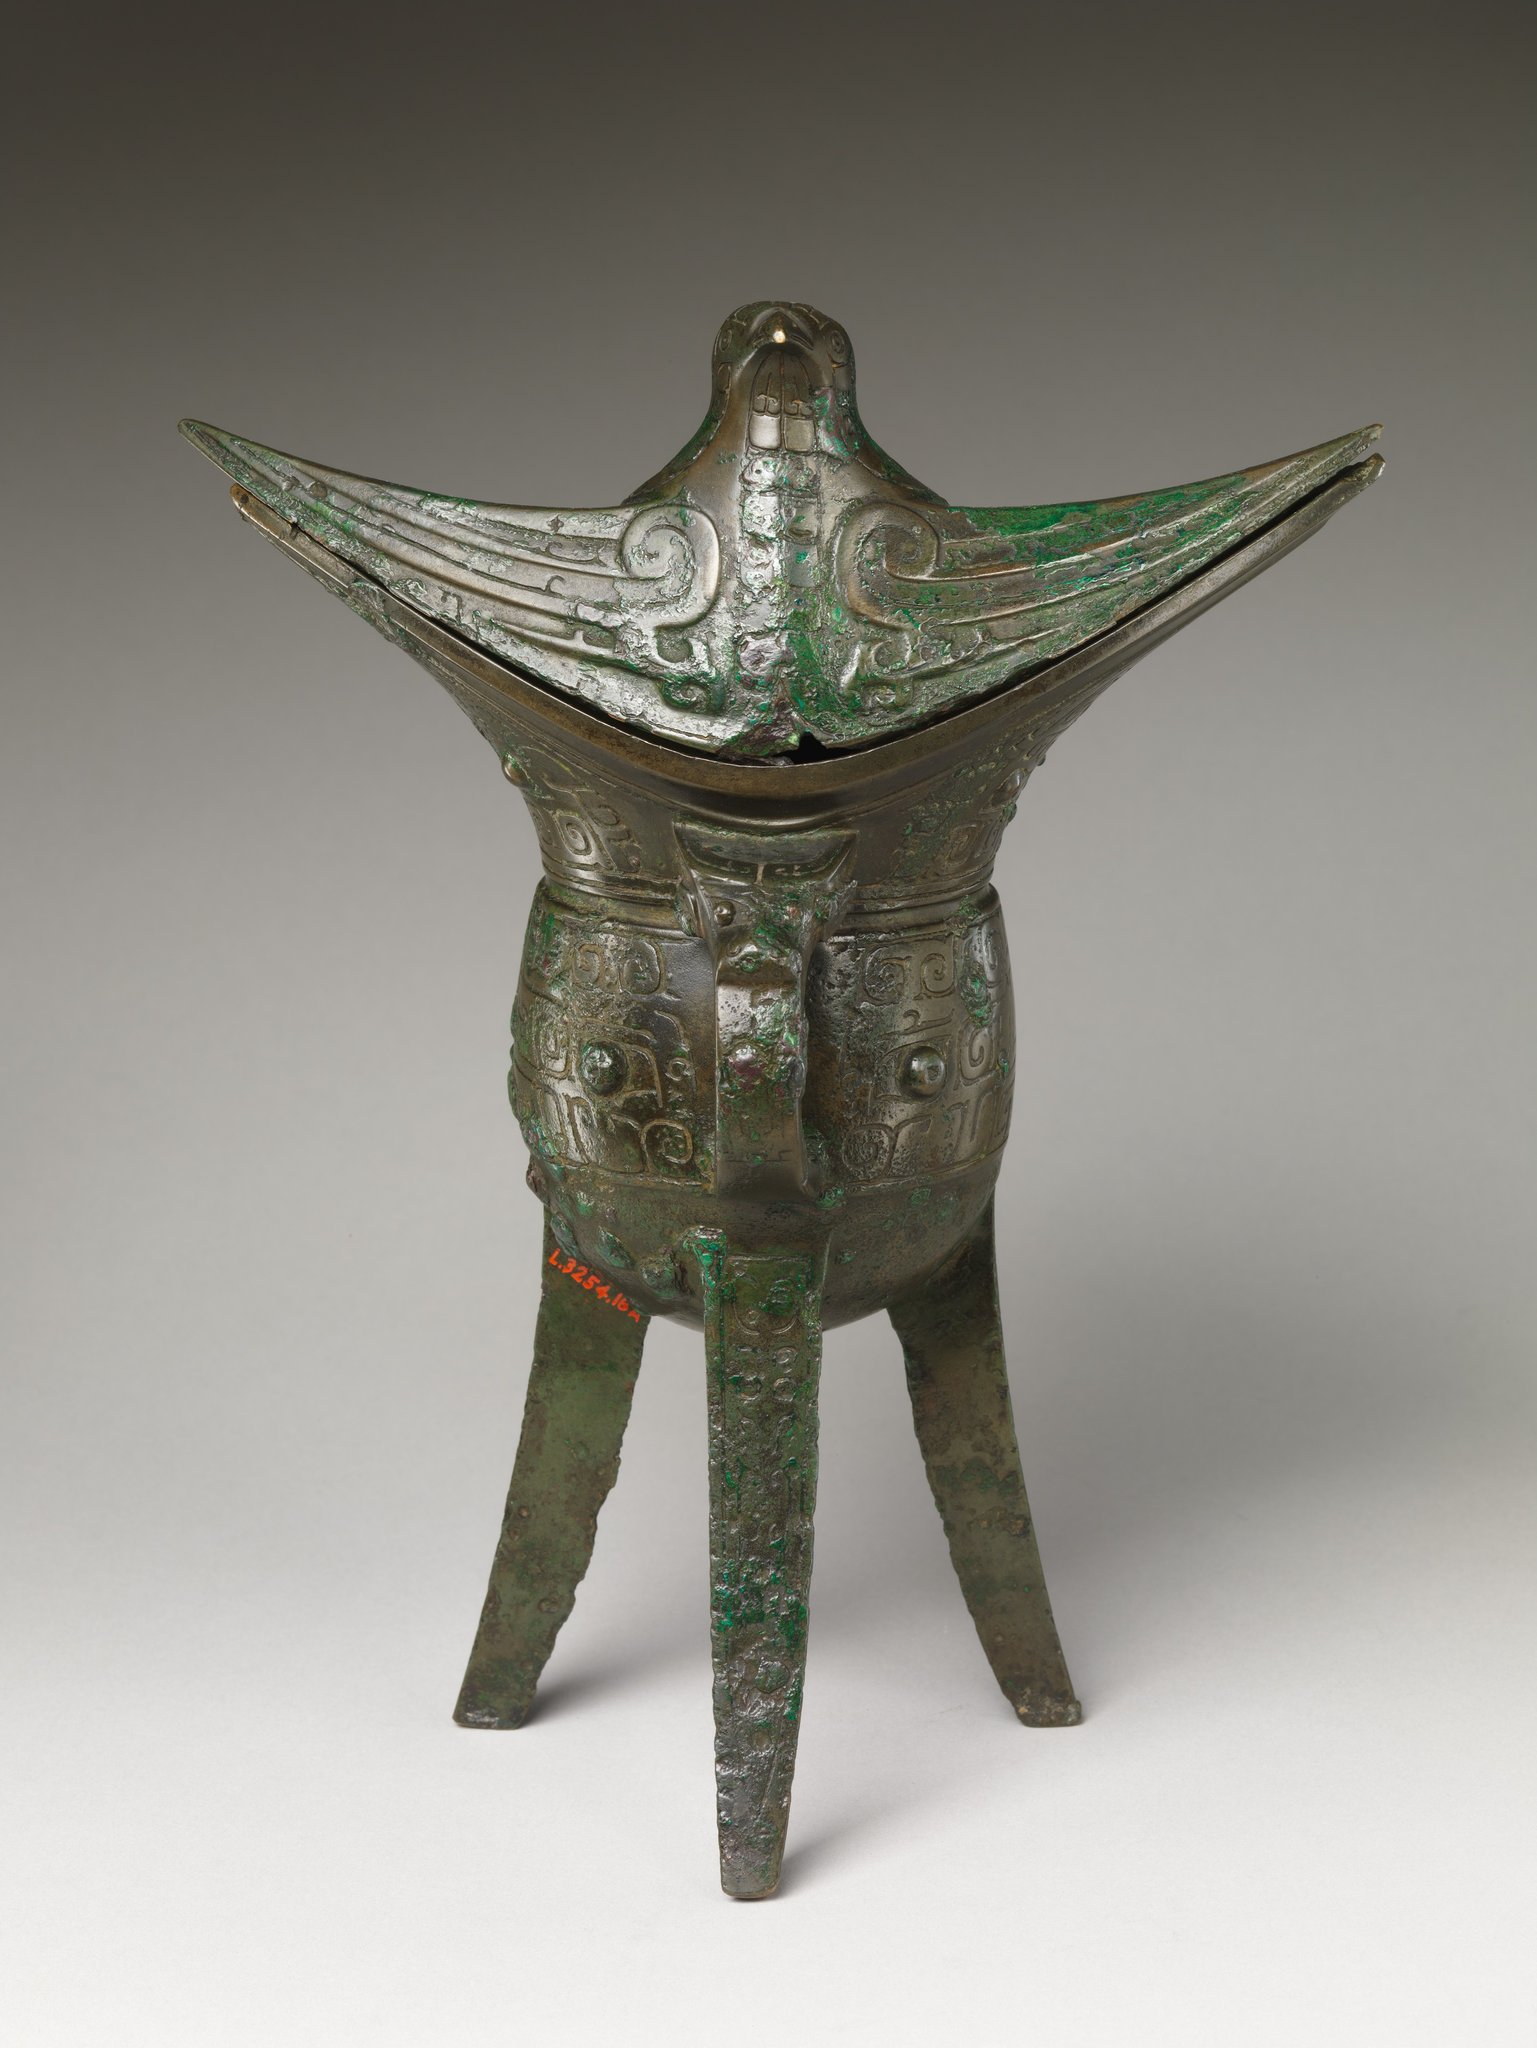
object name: covered wine cup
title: Covered Wine Cup (Jiao)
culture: chinese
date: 1368-1644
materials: bronze